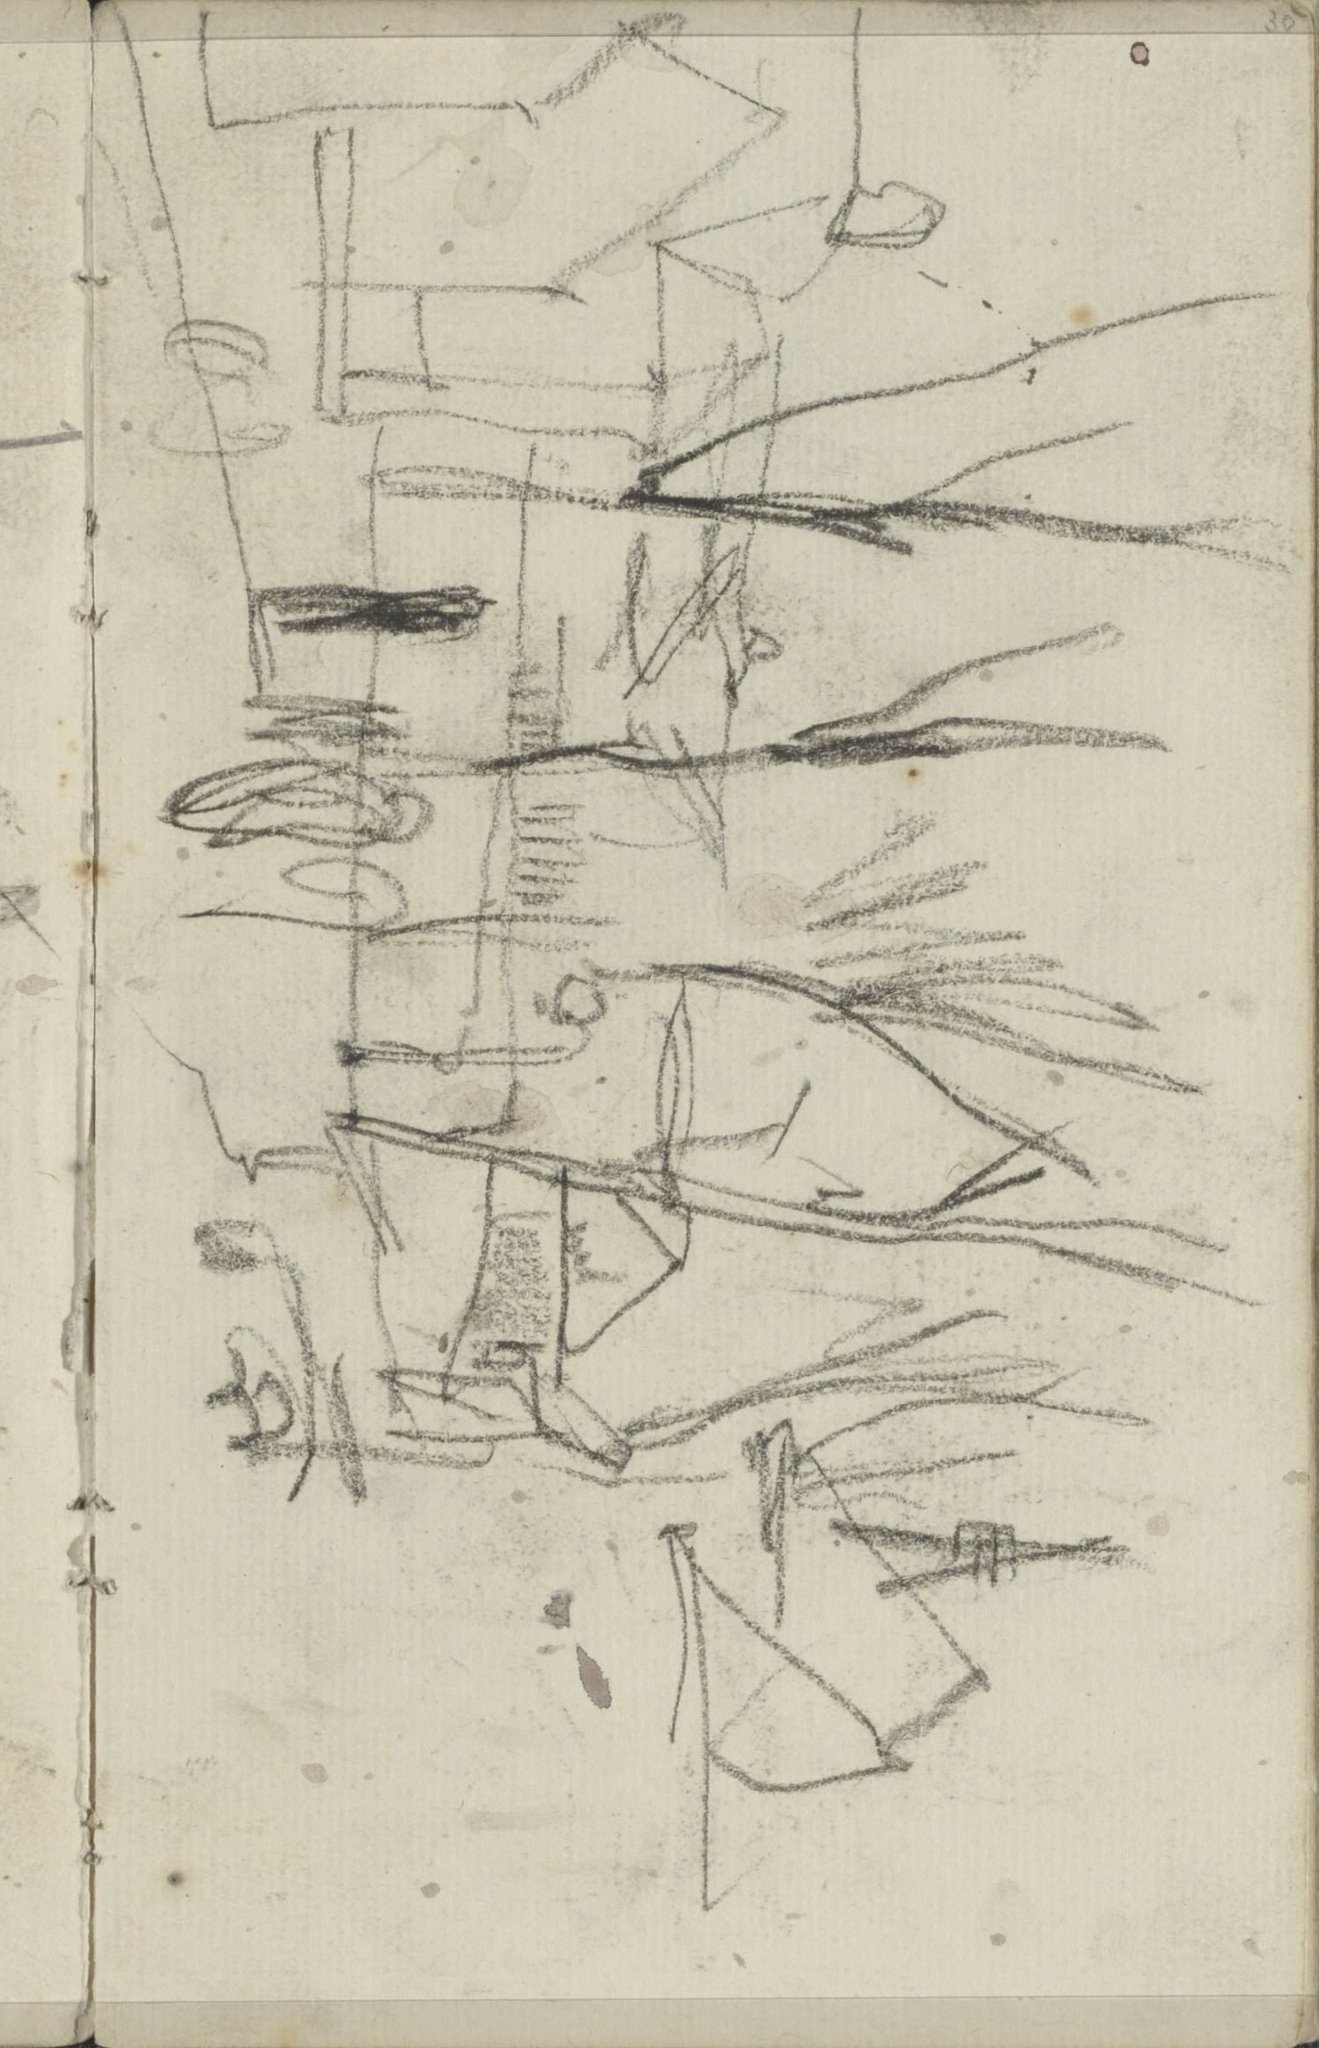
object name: sketchbook leaf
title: Stadsgezicht met figuren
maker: george hendrik breitner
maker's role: draughtsman, painter, print maker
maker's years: 1857-1923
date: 1887-1889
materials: chalk, paper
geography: the hague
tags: trees, civic architecture; edifices; dwellings, city-view, and landscape with man-made constructions (+ city(-scape) with figures, staffage)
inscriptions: annotation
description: Pagina 30 uit een schetsboek met 27 bladen.